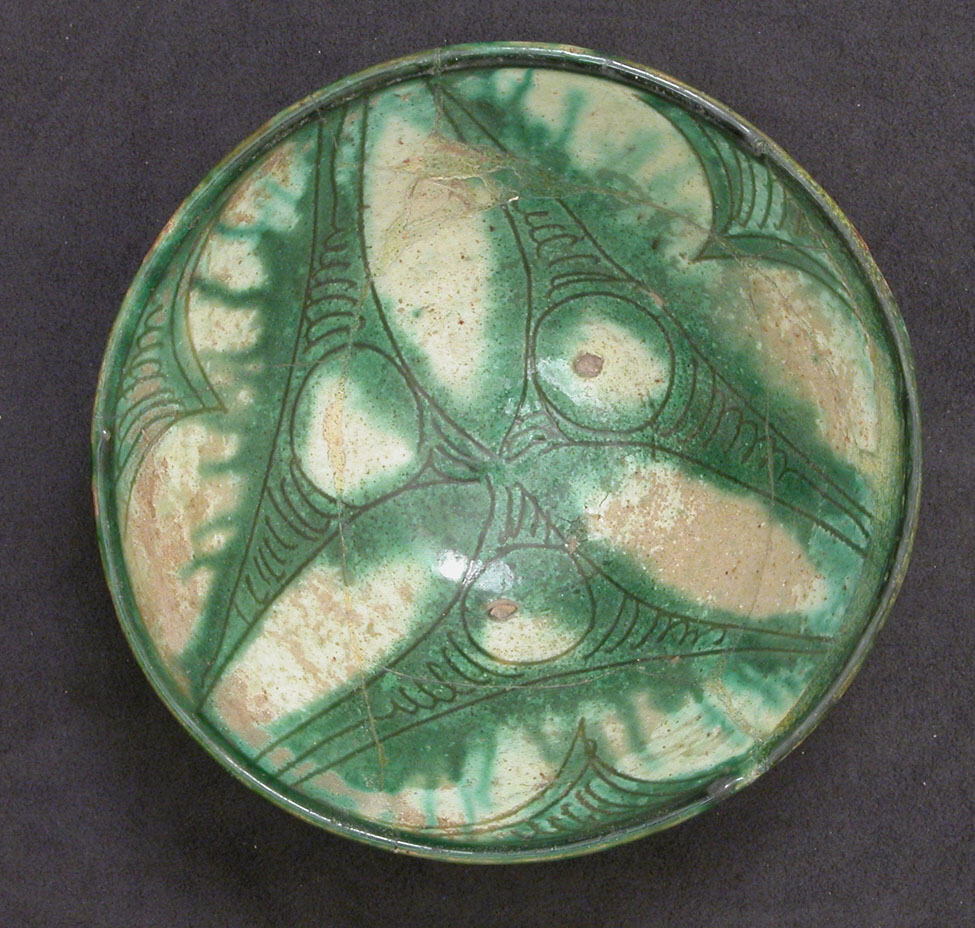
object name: bowl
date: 801-1000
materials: earthenware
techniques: glazing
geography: iran